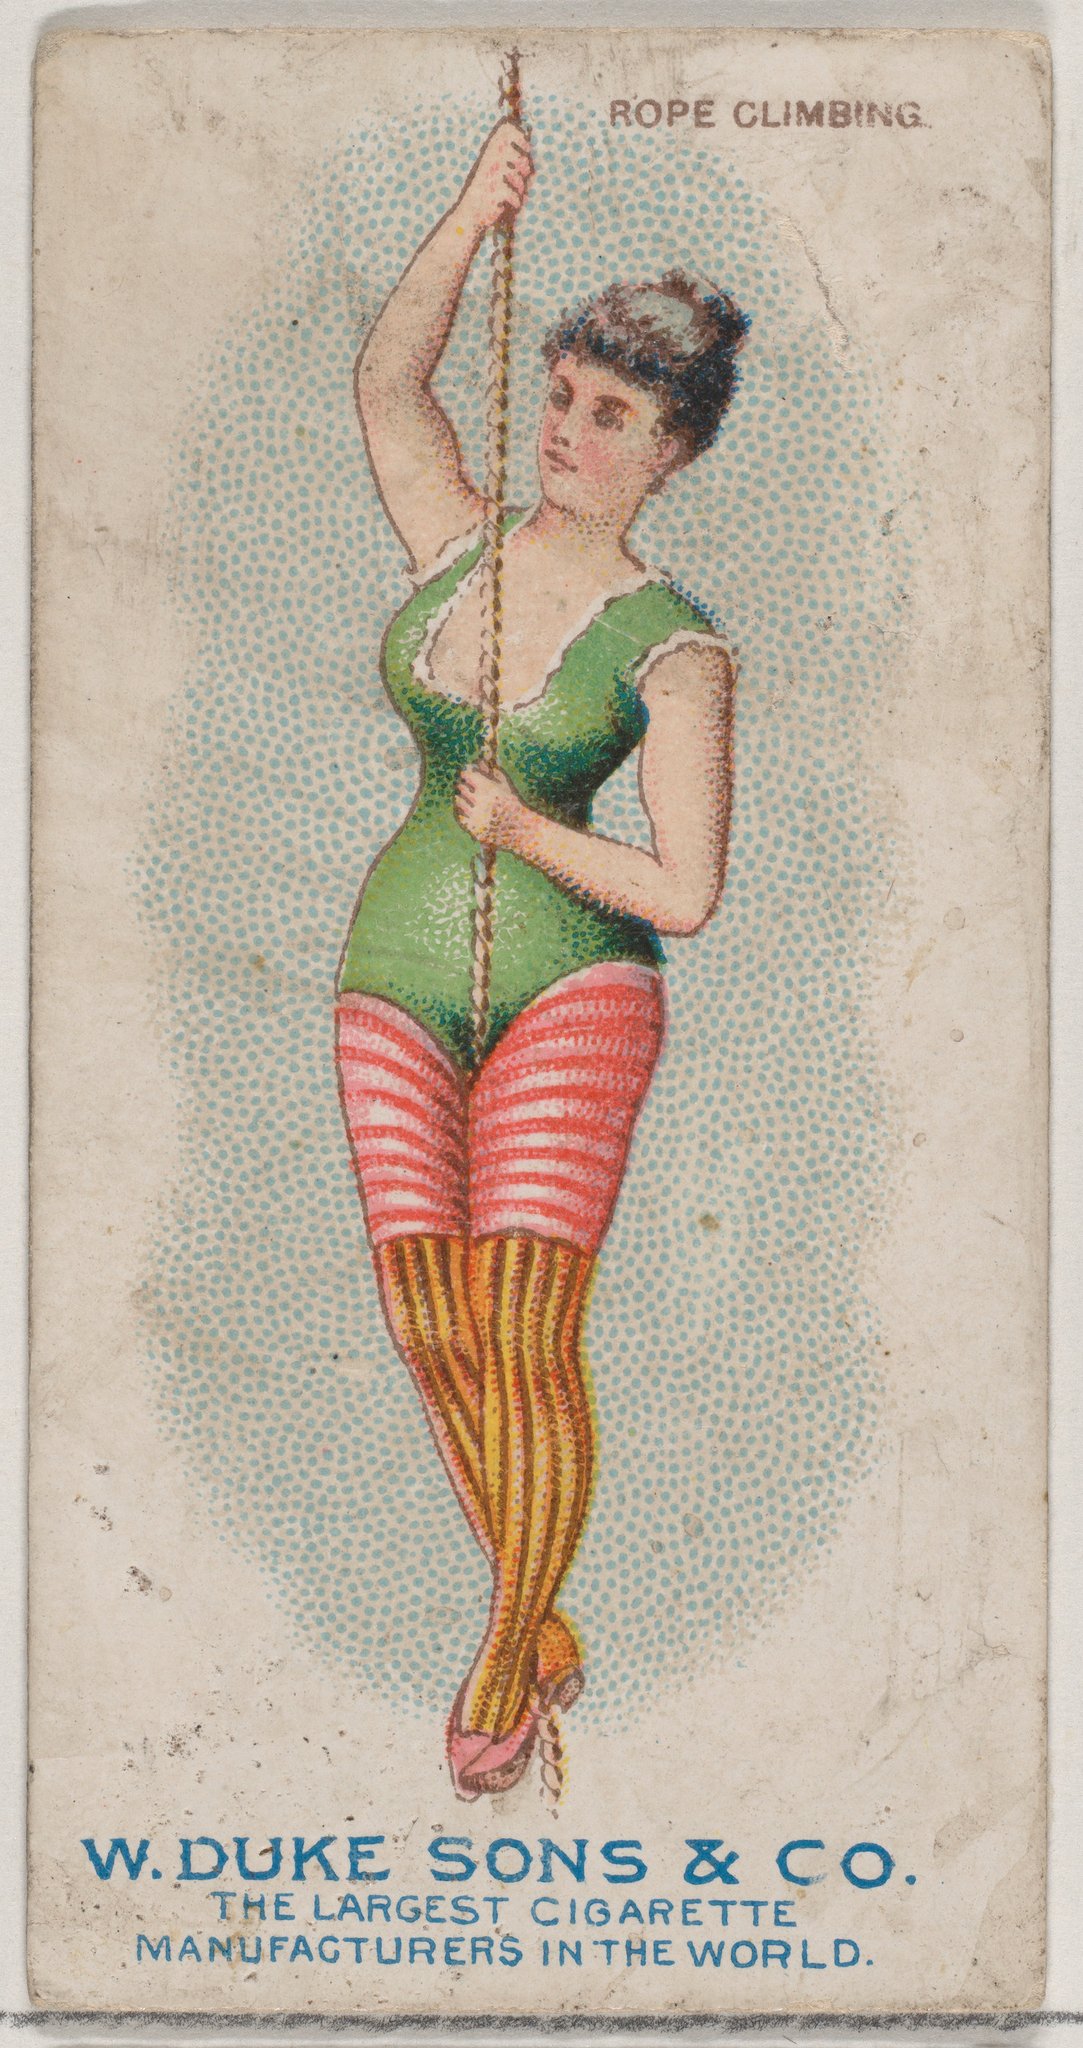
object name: print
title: Rope Climbing, from the Gymnastic Exercises series (N77) for Duke brand cigarettes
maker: w. duke, sons & co.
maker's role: publisher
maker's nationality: american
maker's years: 1870-1920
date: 1887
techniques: color lithograph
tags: women,sports,athletes